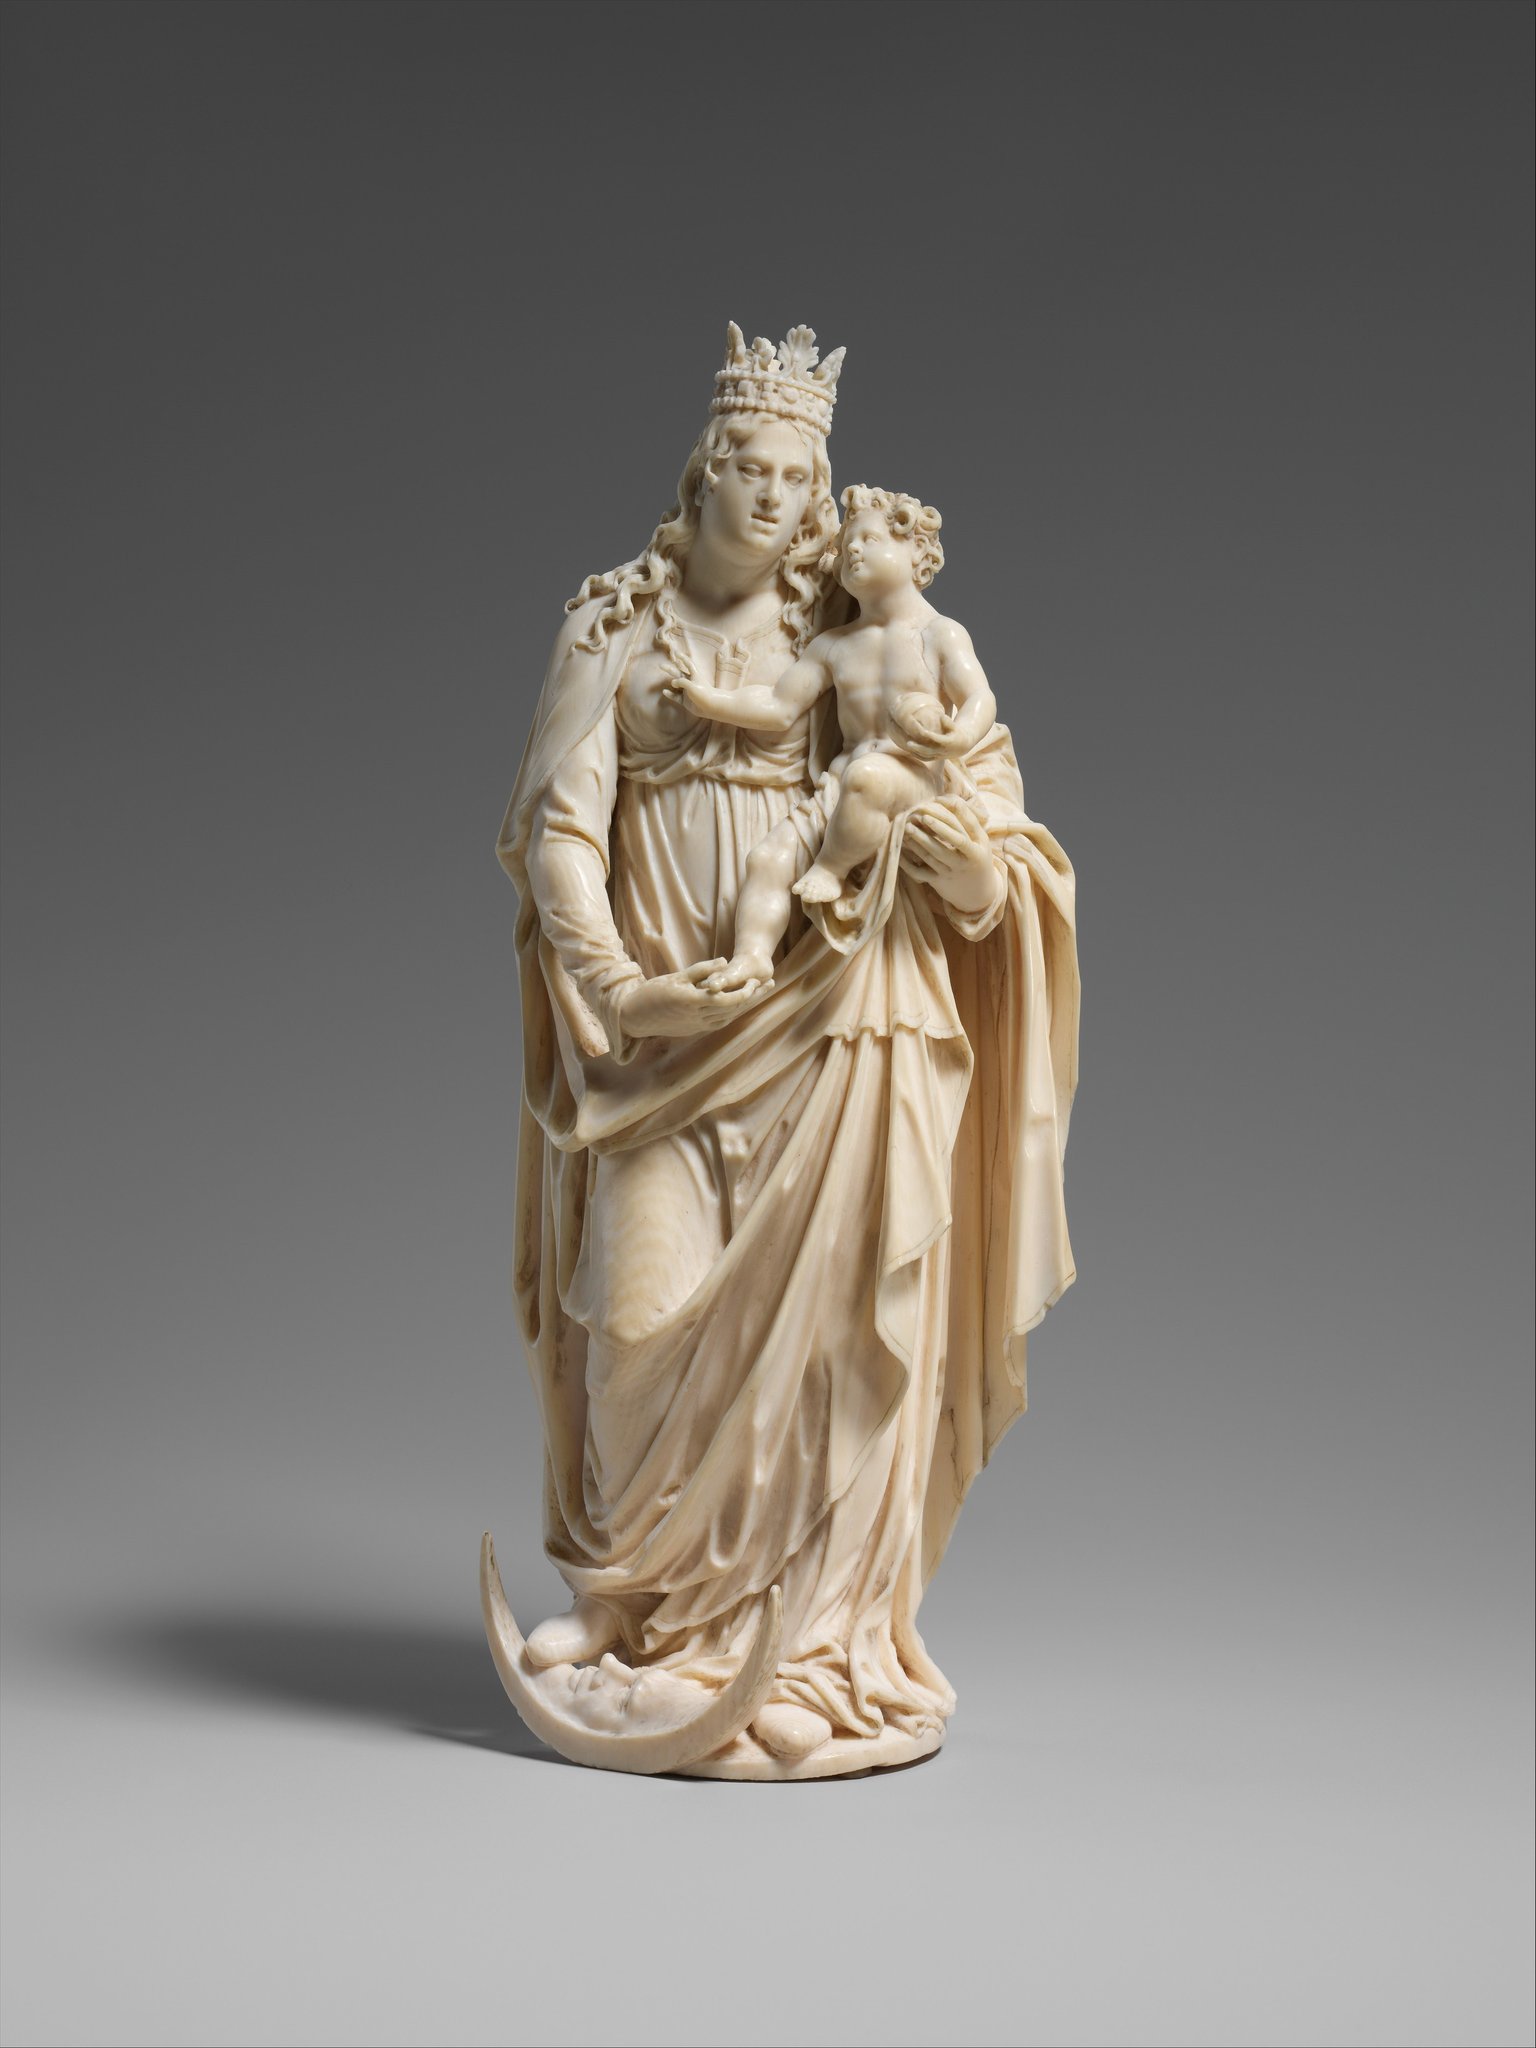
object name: statuette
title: Virgin and Child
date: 1567-1600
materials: ivory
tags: madonna and child